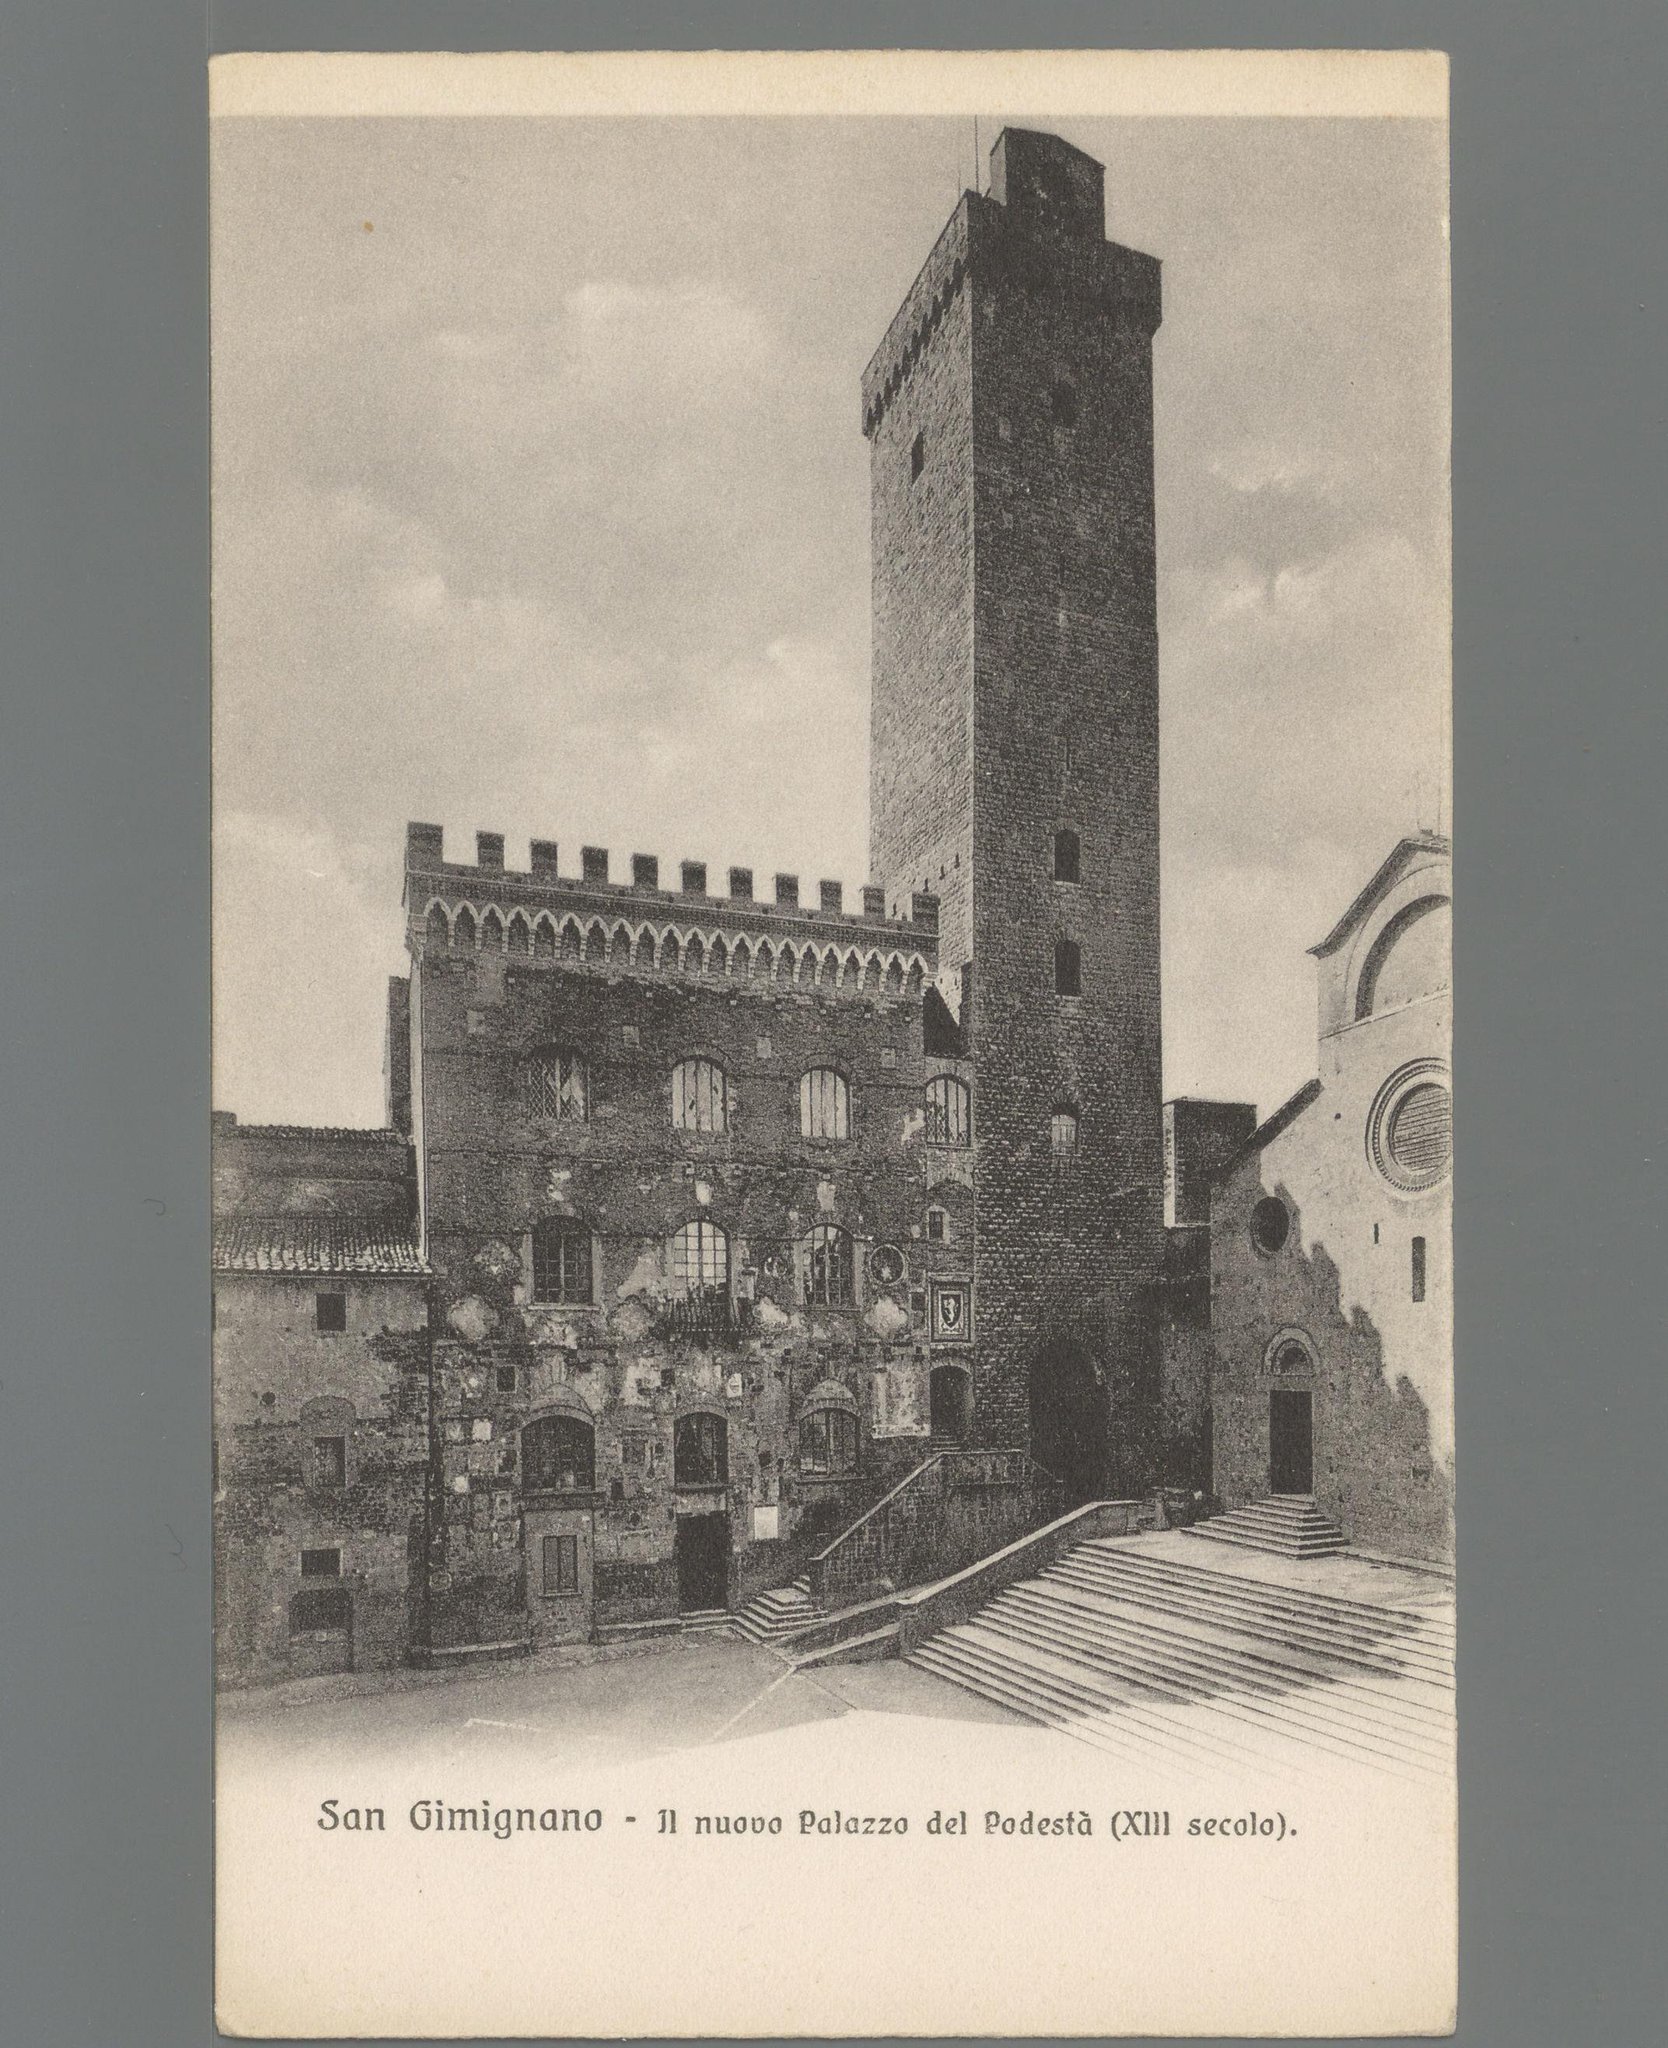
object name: ansichtkaart, prentbriefkaart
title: San Gimignano. Il nuovo Palazzo del Podestà (XIII secolo)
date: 1906-1930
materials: cardboard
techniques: photograph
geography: san gimignano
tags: city-view, and landscape with man-made constructions, palace